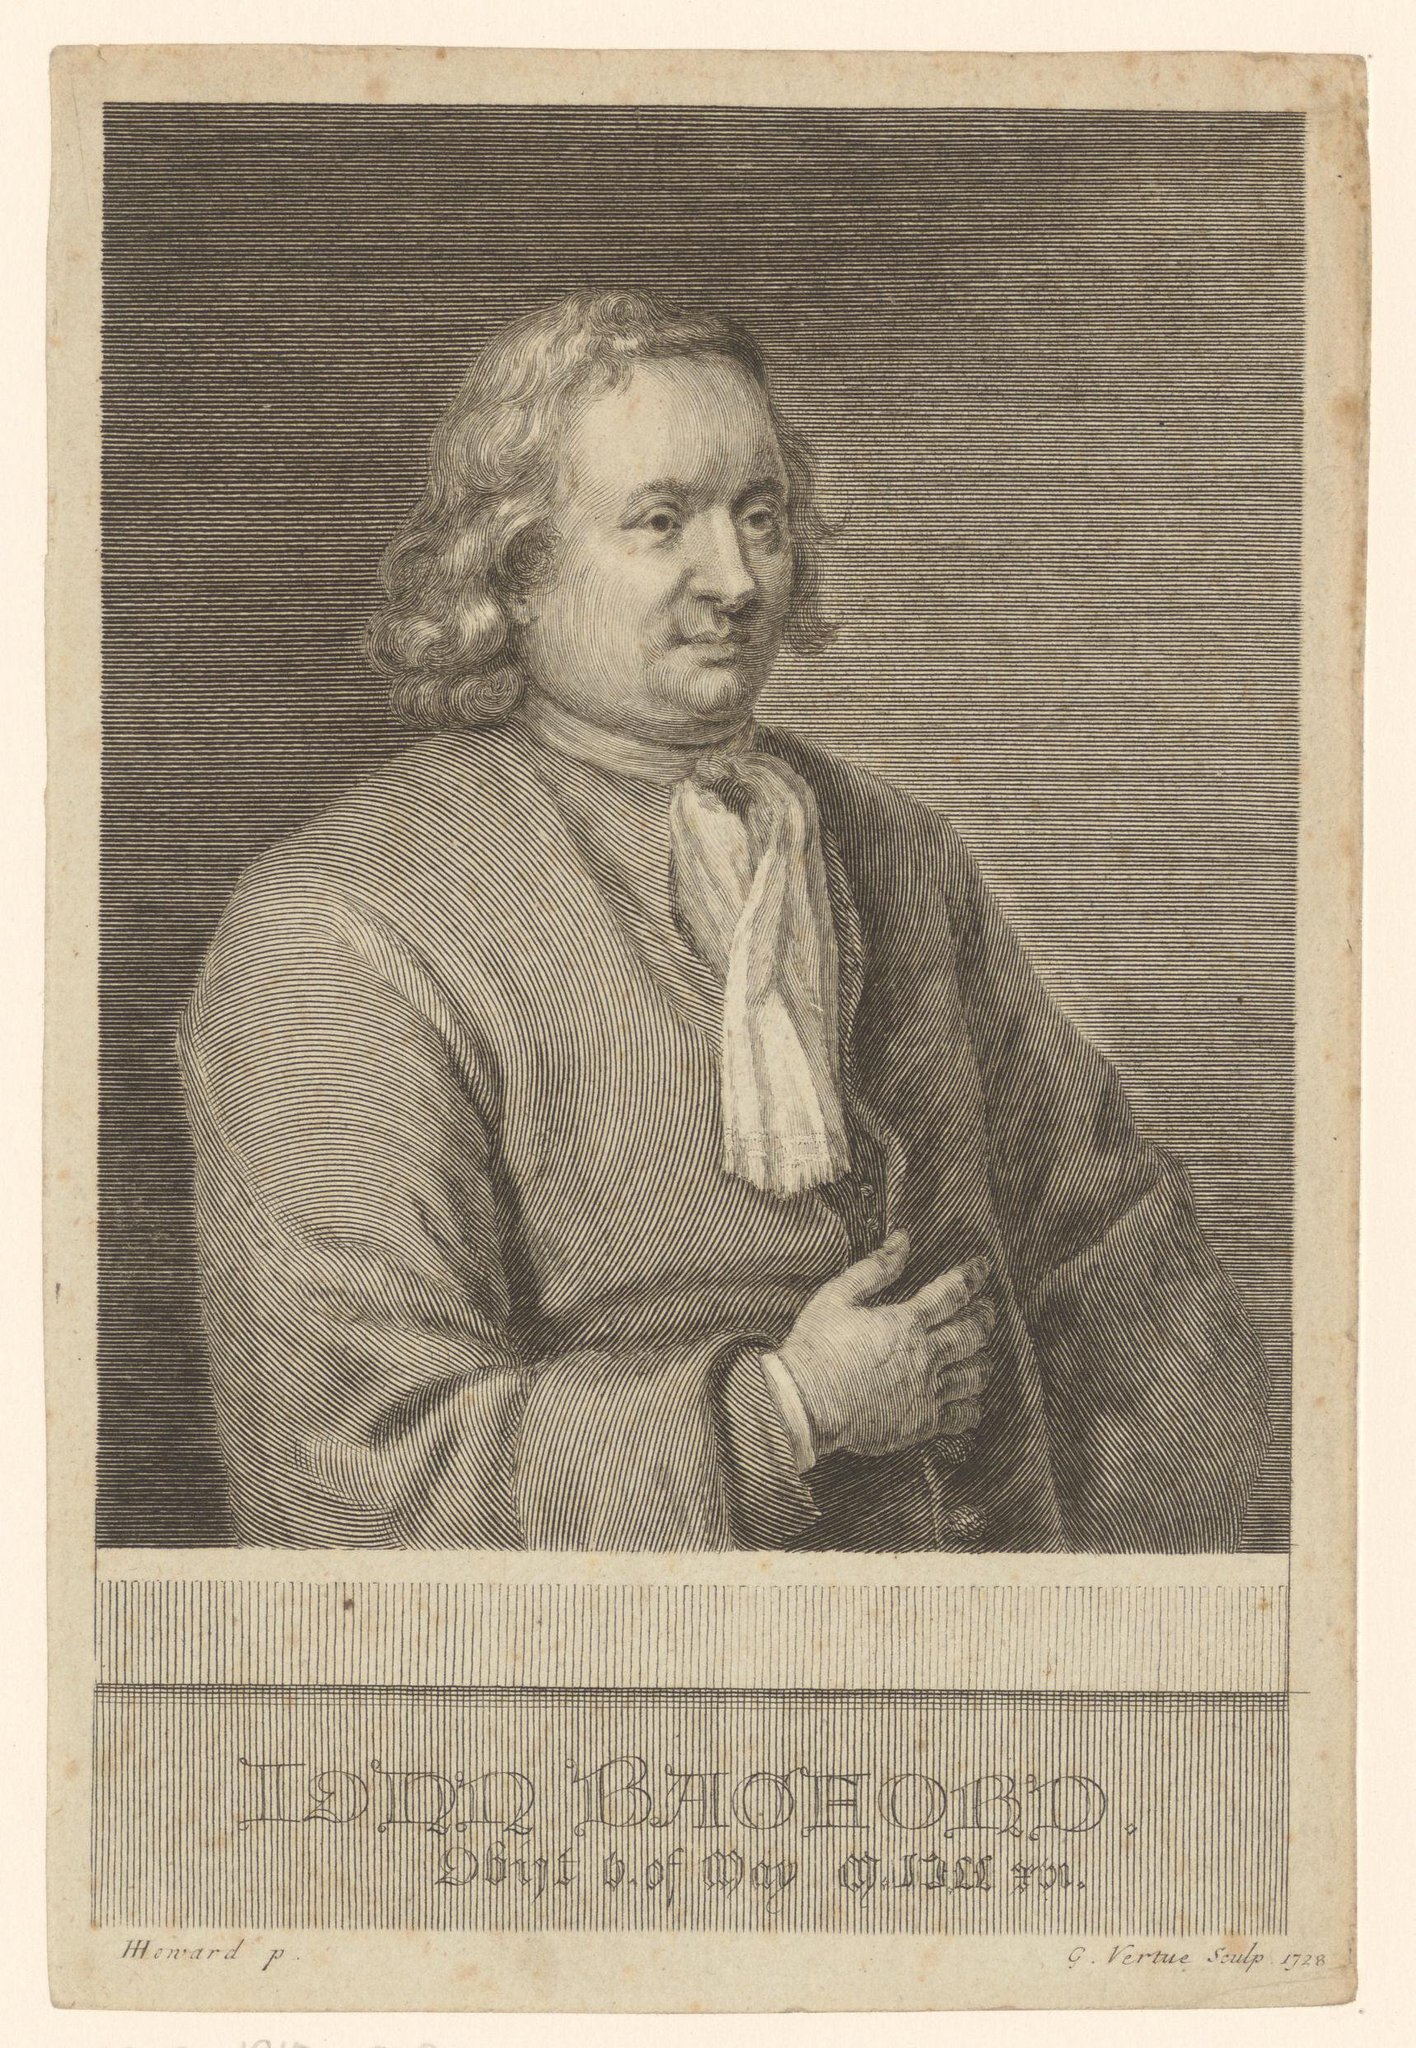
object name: print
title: Portret van John Bedford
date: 1728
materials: paper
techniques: engraving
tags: politician, historical persons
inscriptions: collector's mark: Lugt 2228